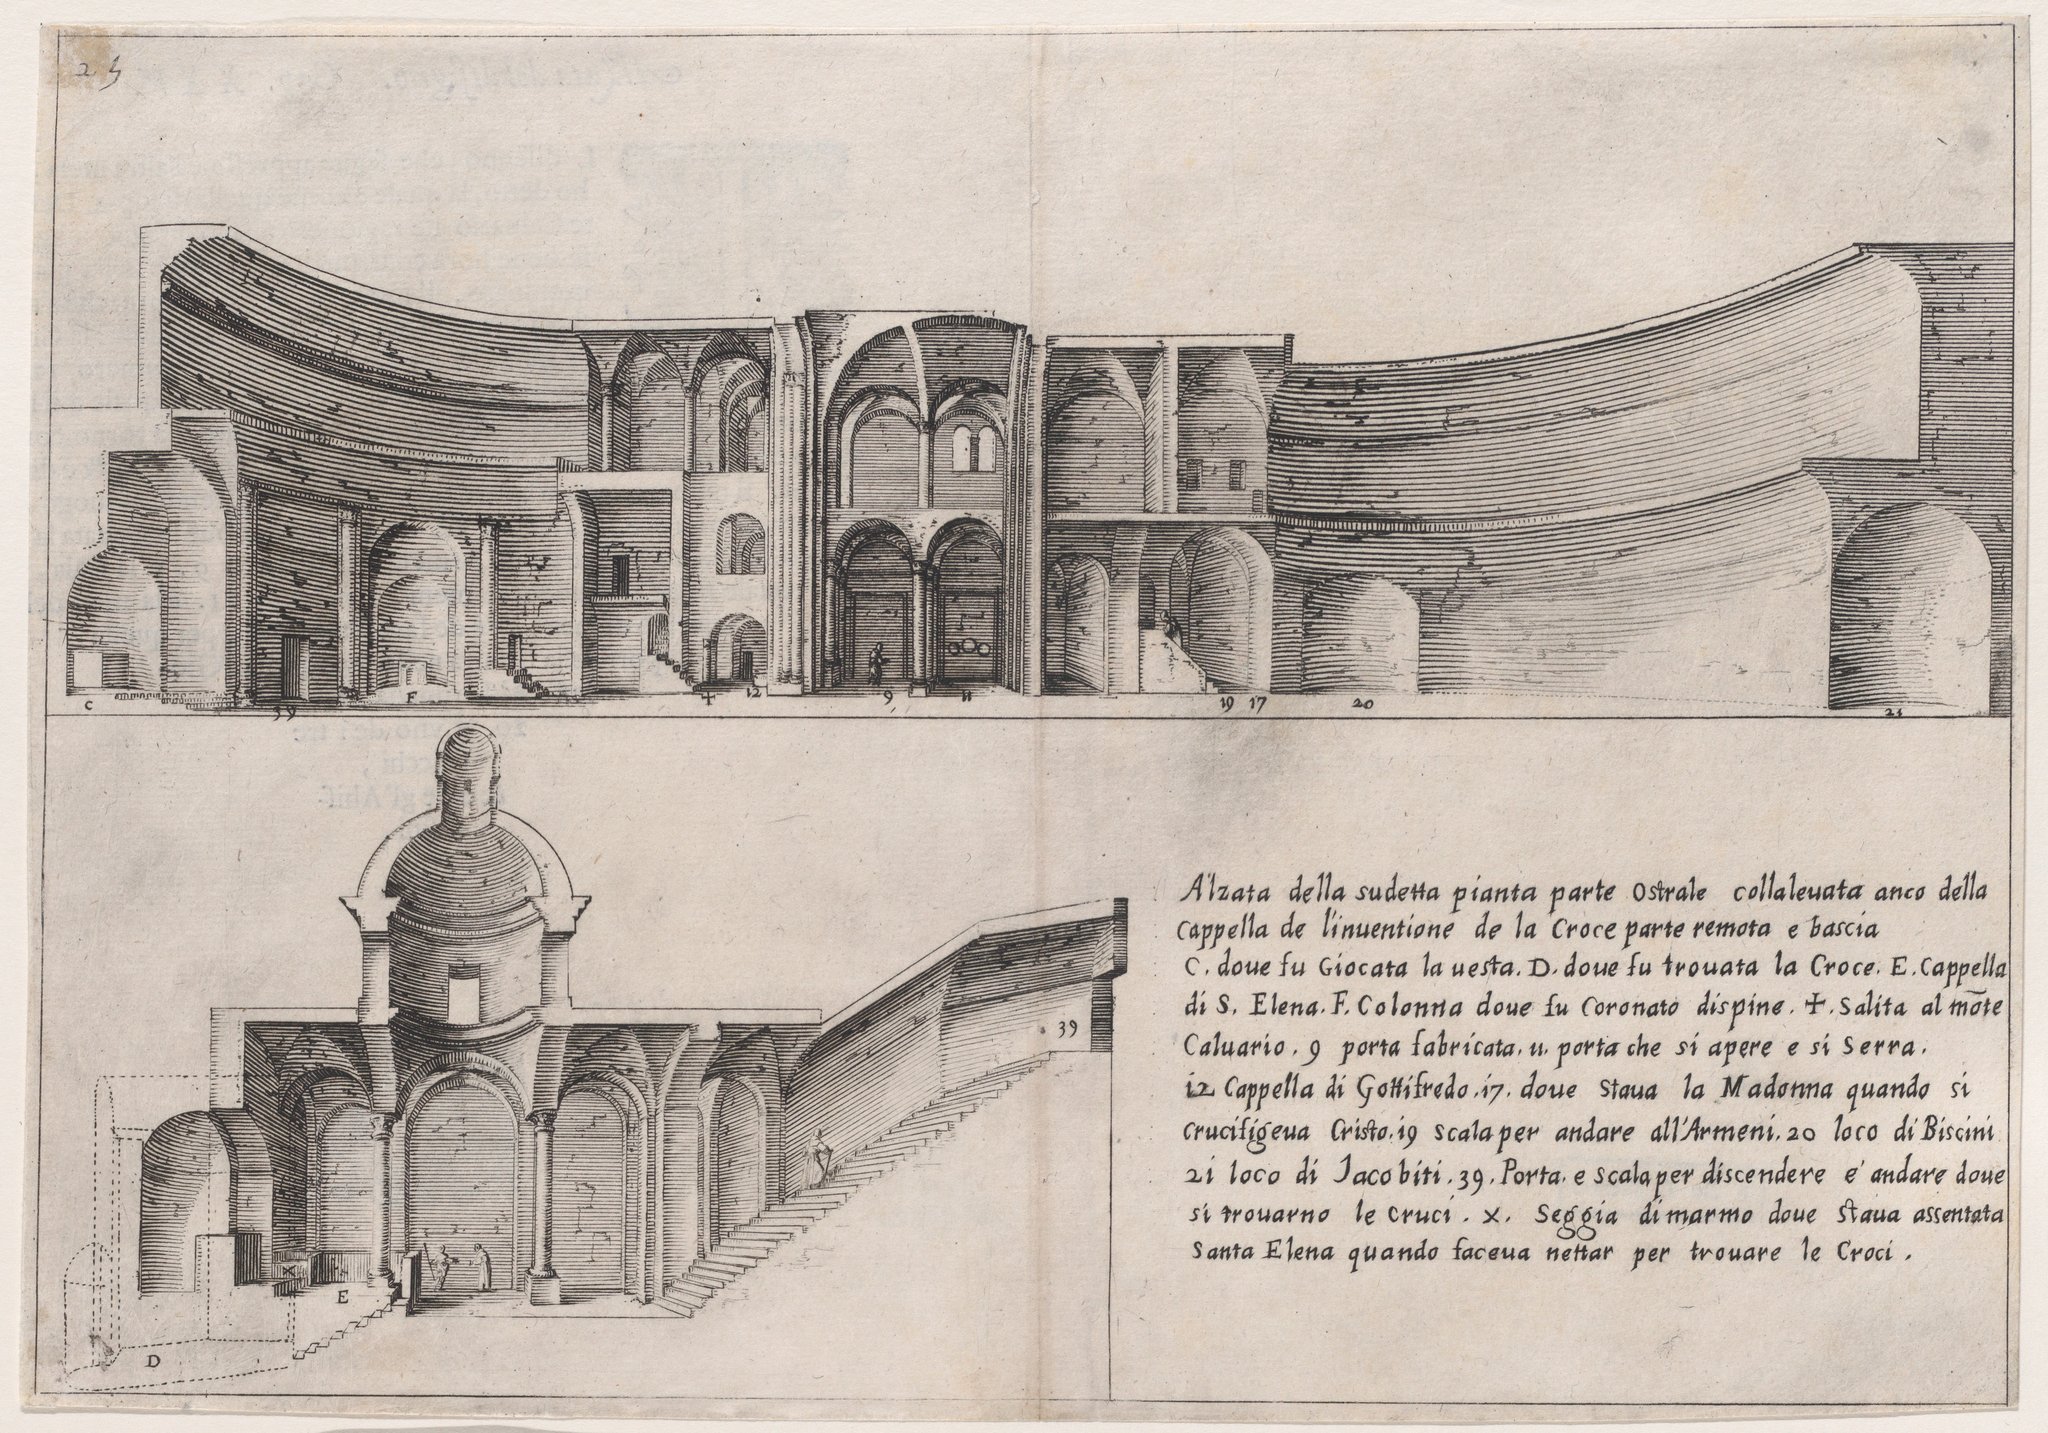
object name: print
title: Plate 21, from "Trattato delle Piante & Immagini de Sacri Edifizi di Terra Santa" (Treatise of the Plans & Images of the Sacred Buildings of the Holy Land)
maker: jacques callot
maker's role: artist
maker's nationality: french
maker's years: 1592-1635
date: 1620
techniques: engraving, etching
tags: architecture,buildings